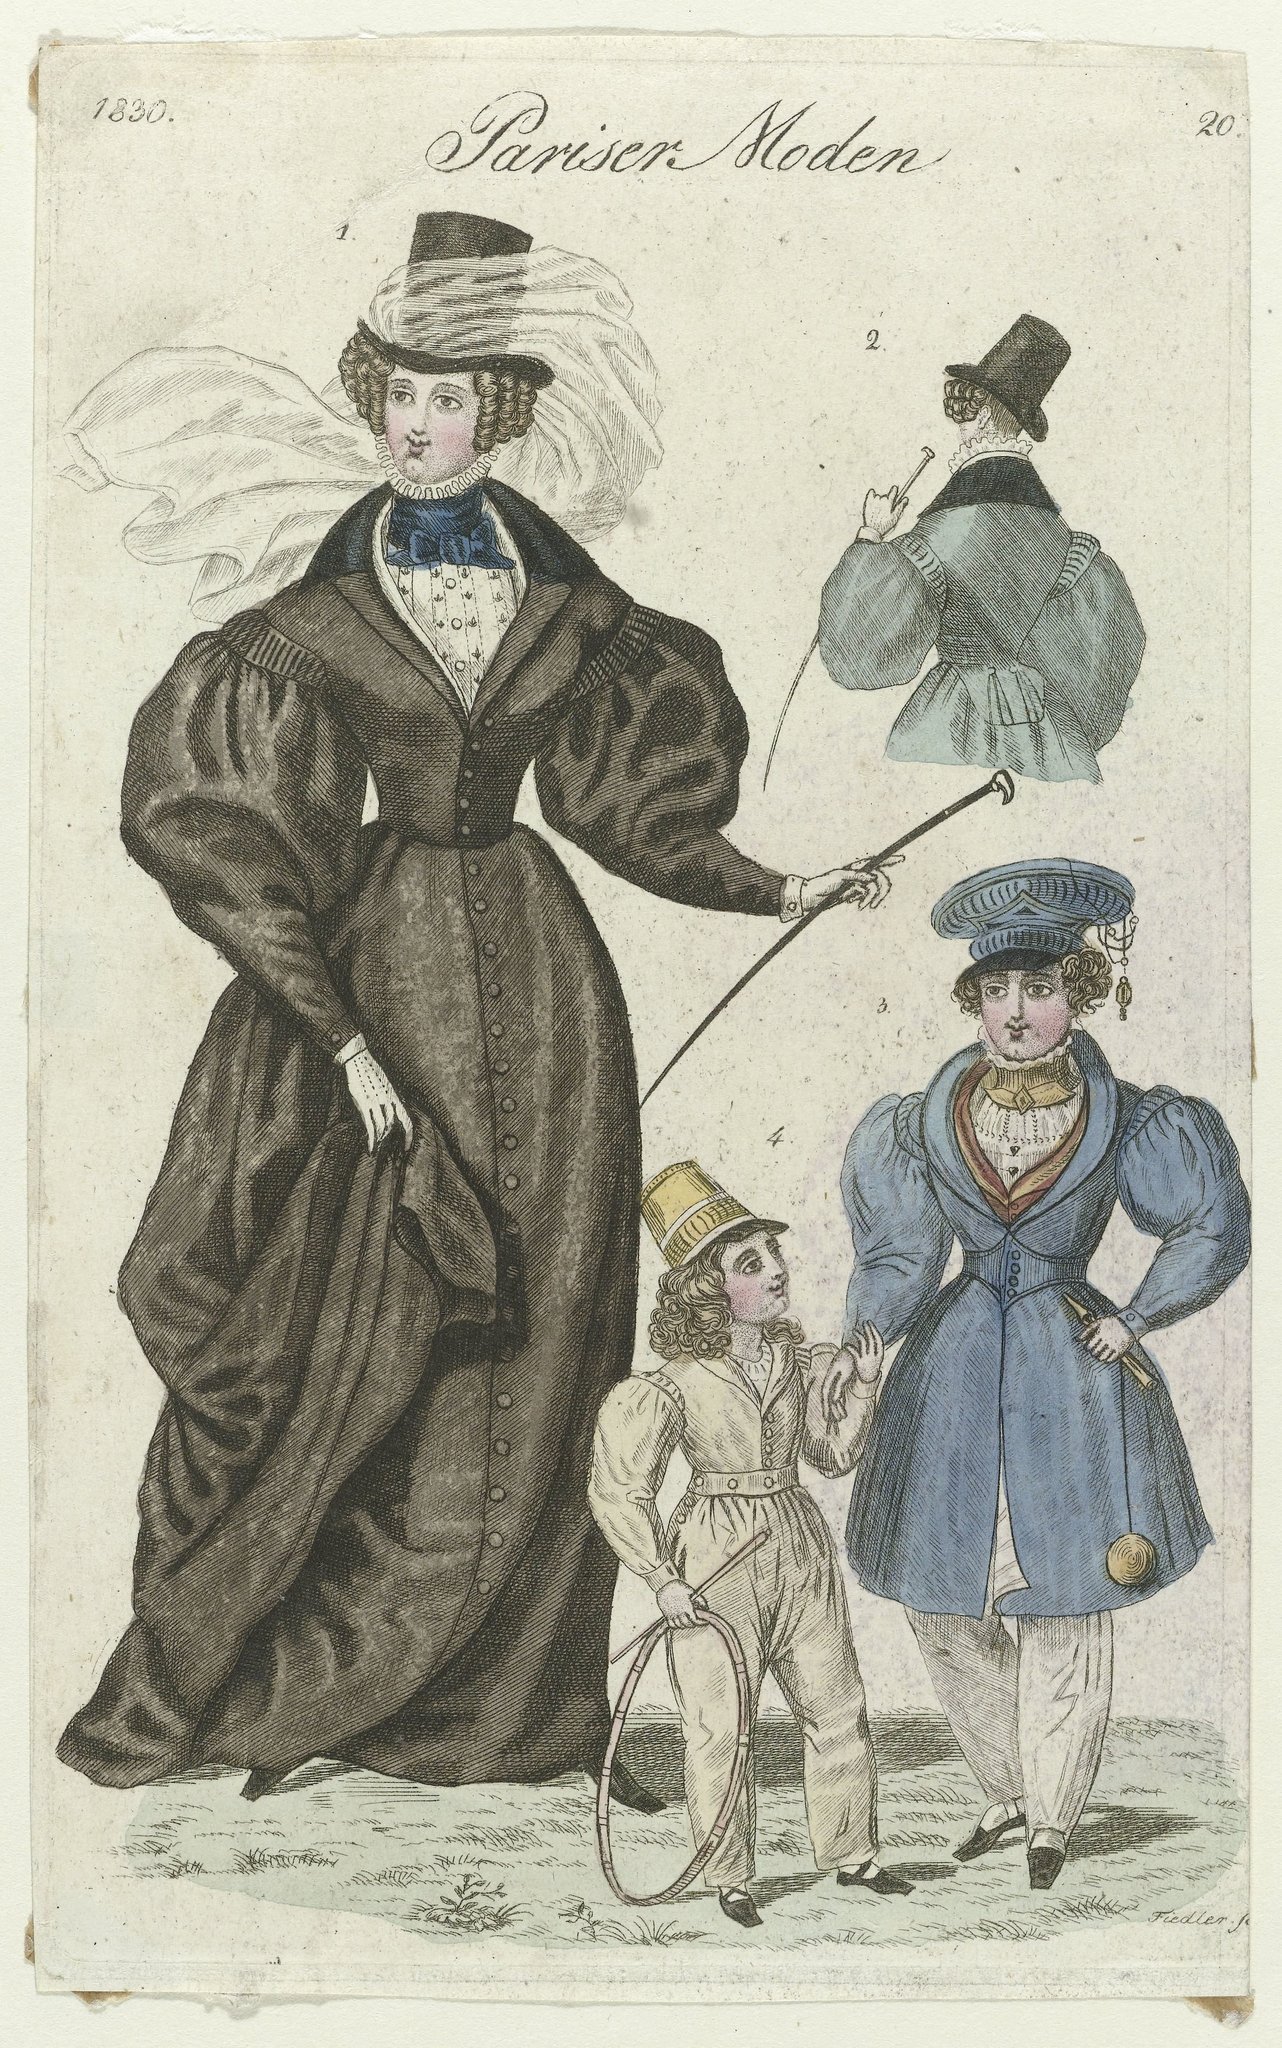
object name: fashion print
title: Pariser Moden, 1830, nr. 20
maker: Anonymous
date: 1830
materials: paper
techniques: engraving, hand coloring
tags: veil (+ women's clothes), head-gear: hat (+ boys' clothes), trousers, breeches, etc. (pantalon) (+ boys' clothes), clothes, costume (+ boys' clothes), fashion plates, dress, gown (+ women's clothes), ball games, whip, ensembles of pieces of clothing (riding costume) (+ women's clothes), riding a horse, ass, or mule; rider, horseman (+ sitting on animal with both legs on one side, riding side-saddle)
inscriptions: title: ‘Pariser Moden’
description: Staande vrouw gekleed in een amazonekostuum (rijkostuum). Op het hoofd een hoge hoed met sluier. Zweep in de hand. Rechtsboven is de achterzijde verkleind weergegeven. Rechtsonder twee kinderen, van wie één met hoepel en stokje in de hand. De kinderen zijn waarschijnlijk gekopieerd naar No. 718 van Petit Courrier des Dames.